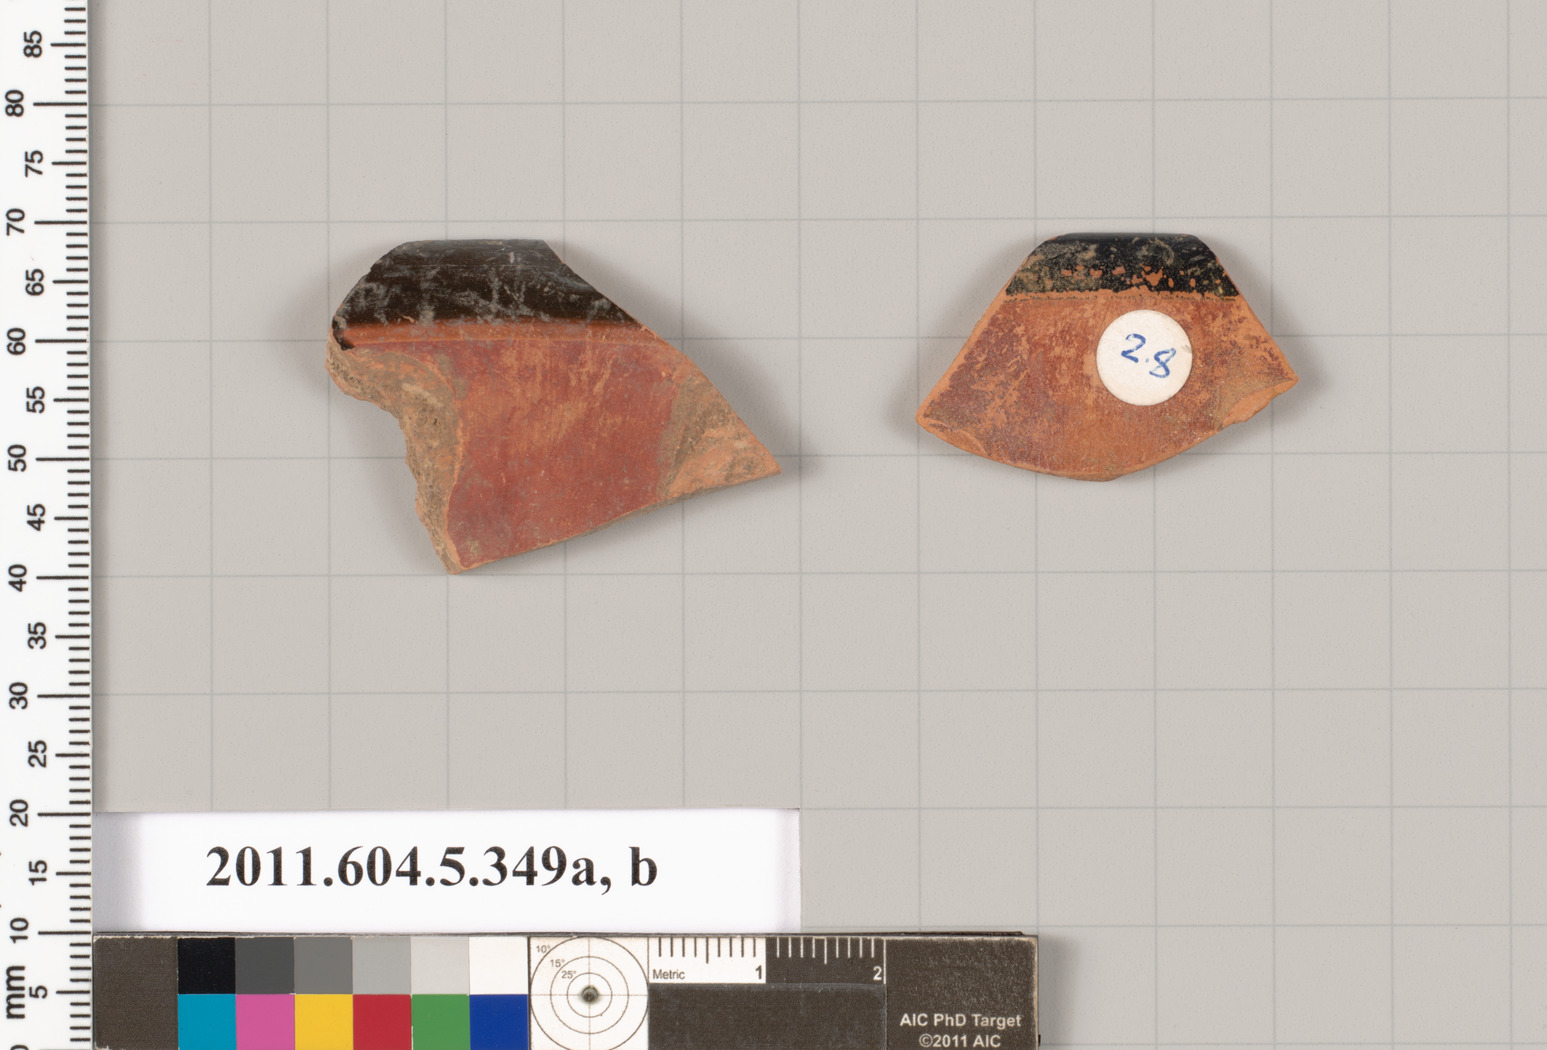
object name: kylix fragment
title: Terracotta rim fragments of kylikes (drinking cups)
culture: greek, attic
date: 600-401 BCE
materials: terracotta